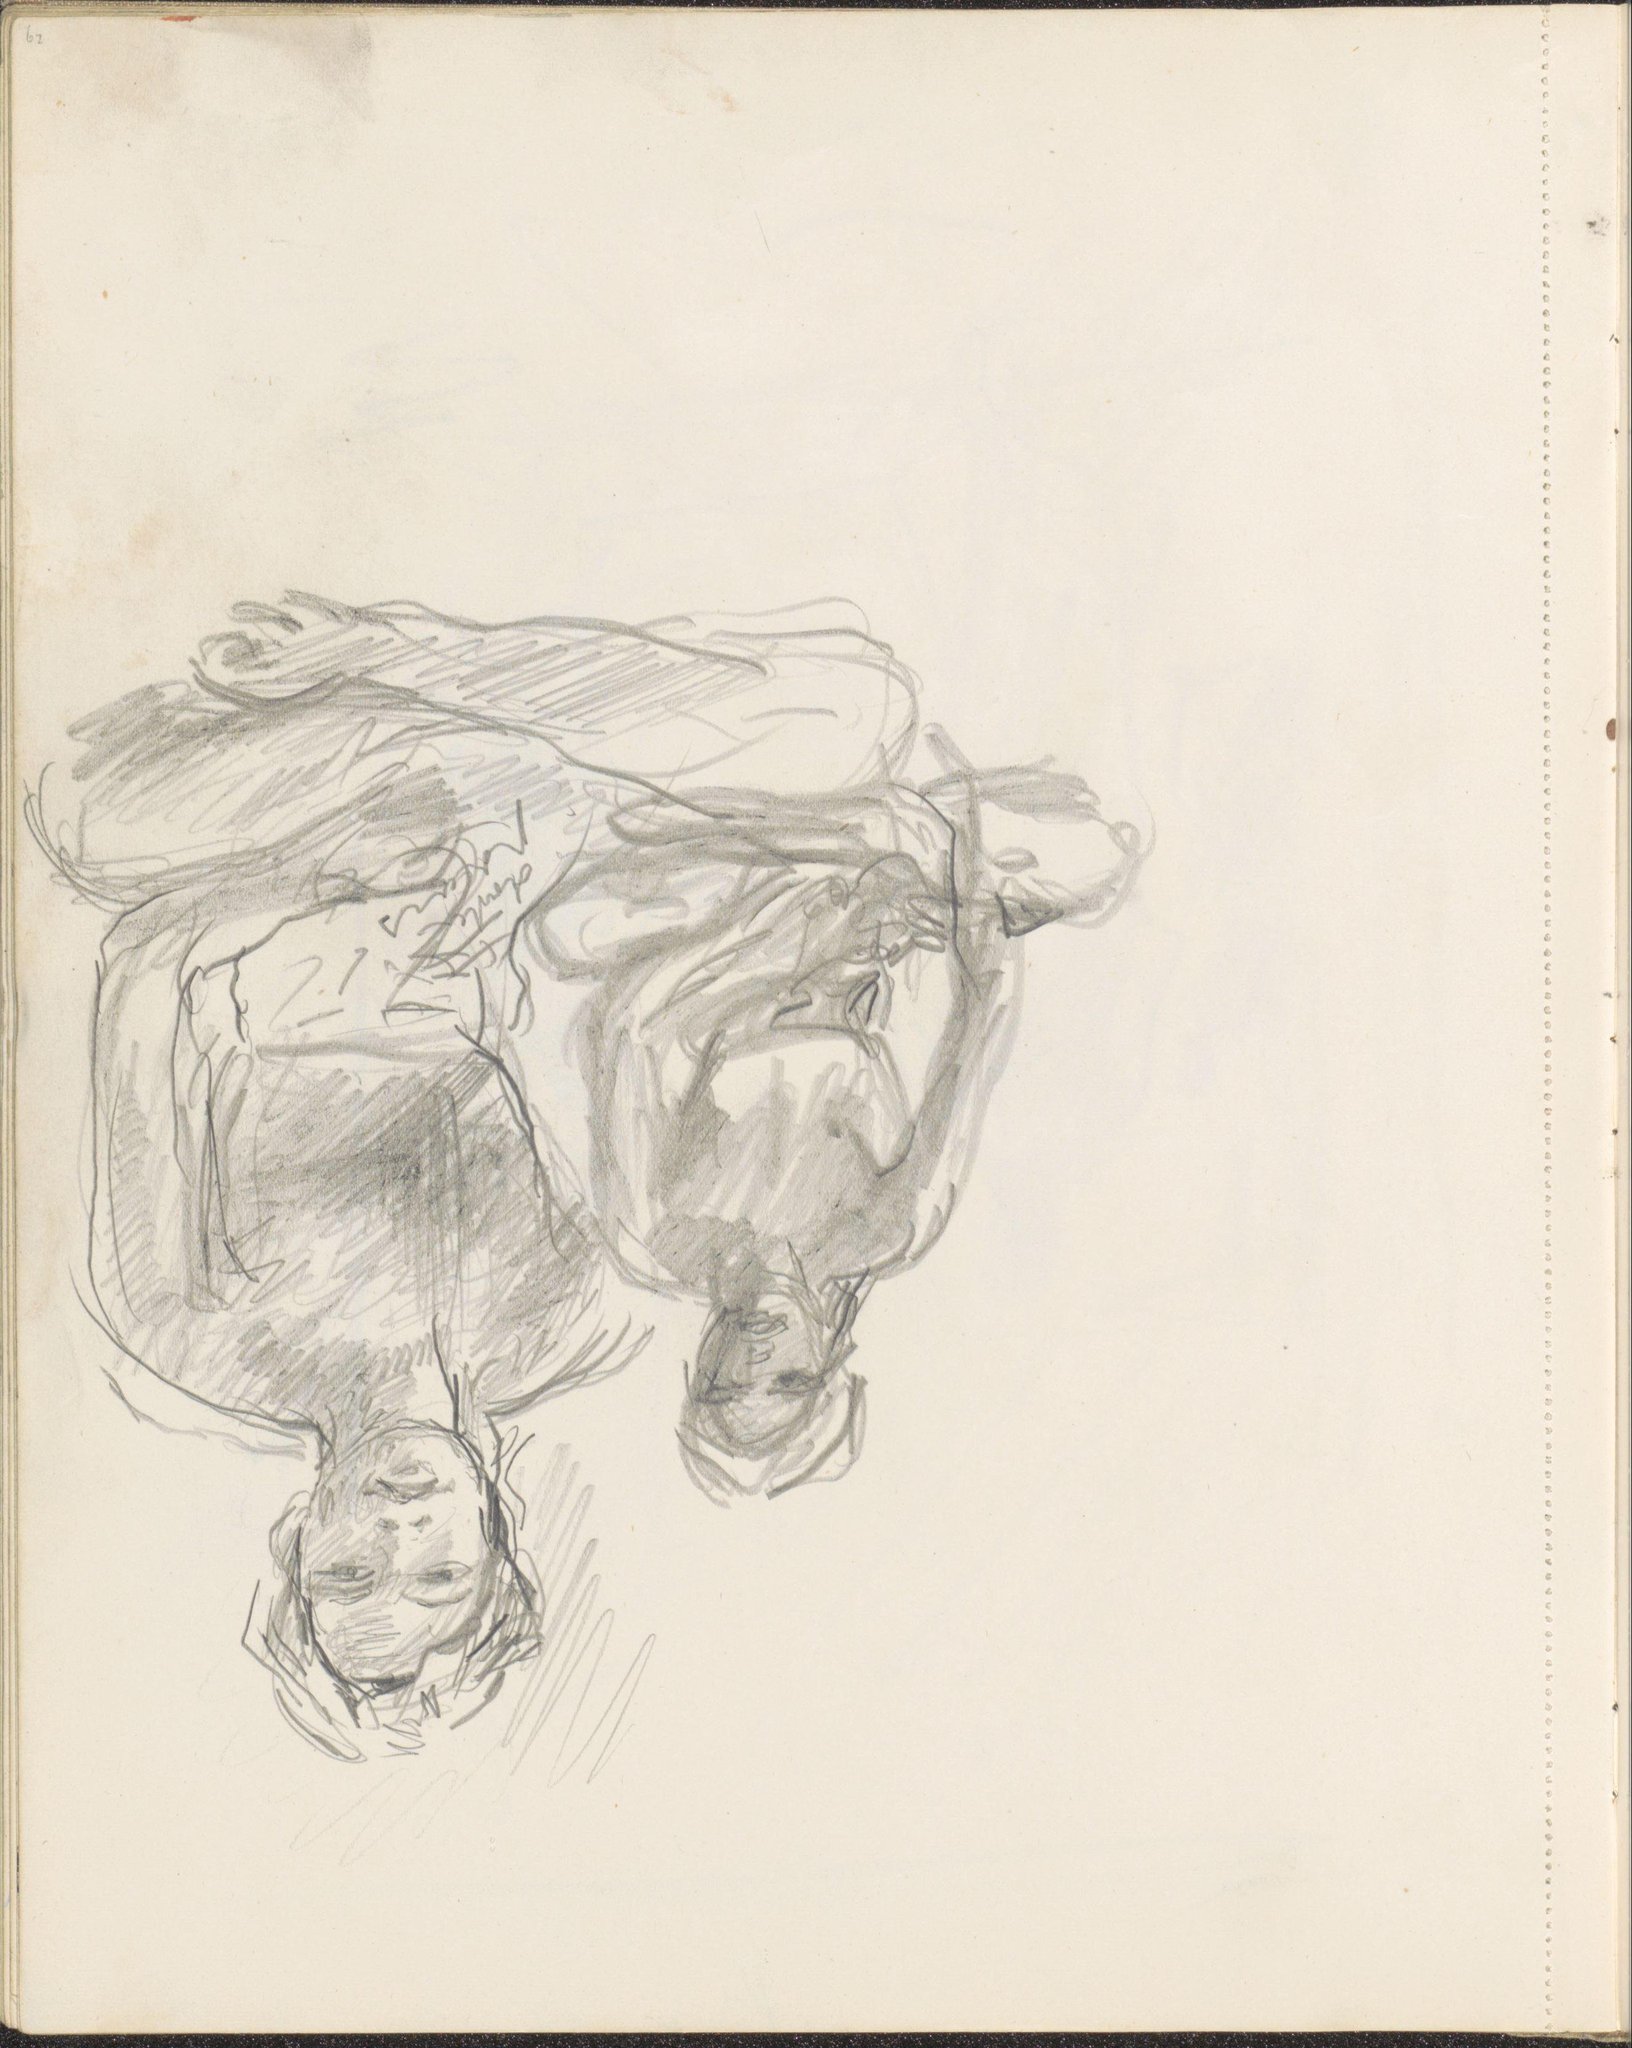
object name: sketchbook leaf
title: Twee zittende mannen in lendendoeken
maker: marius bauer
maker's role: draughtsman, print maker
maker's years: 1867-1932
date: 1931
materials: paper, pencil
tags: sitting figure, adult man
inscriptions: kleurnotitie, handgeschreven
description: Pagina 62 uit een schetsboek met 48 bladen.